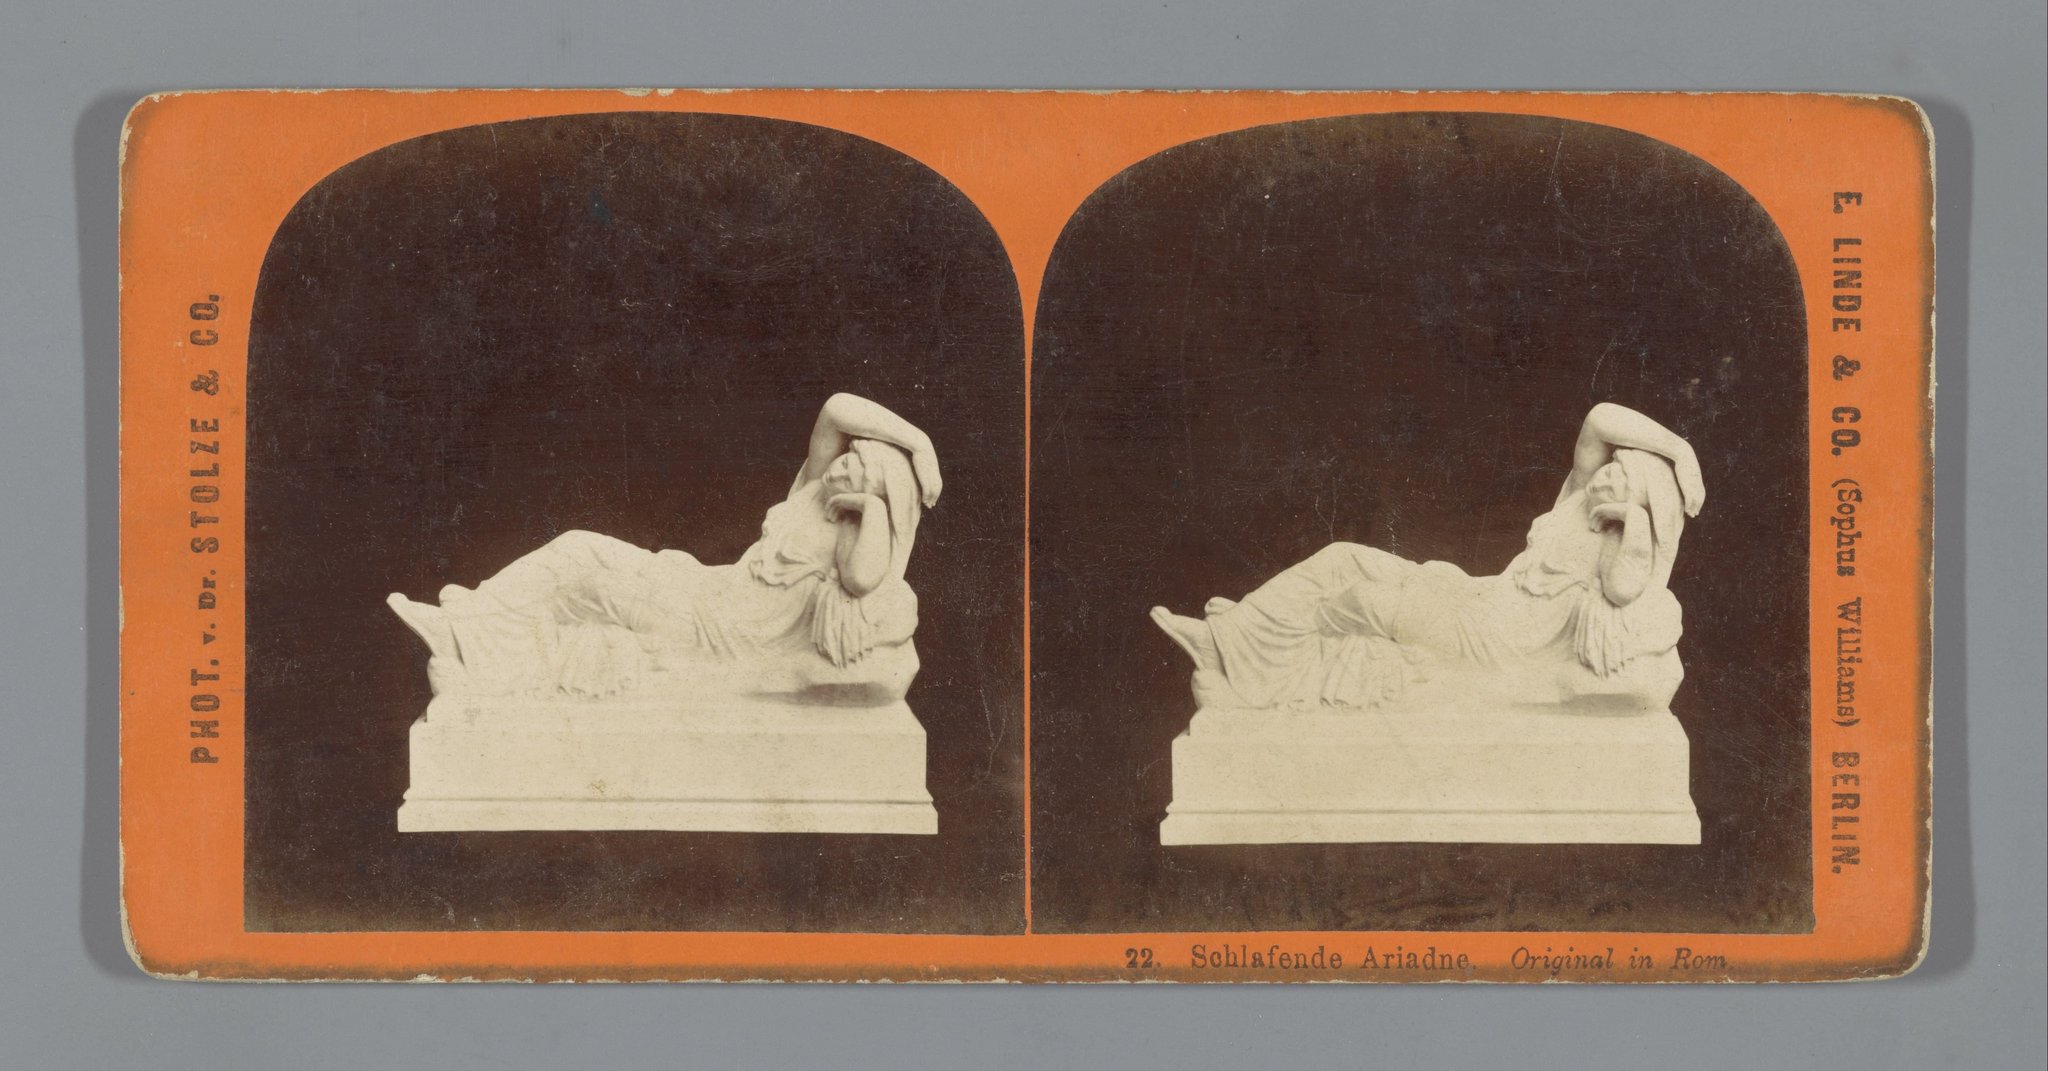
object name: stereograph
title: Sculptuur van de slapende Ariadne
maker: karl heinrich franz stolze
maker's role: fotograaf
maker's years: 1836-1910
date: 1855-1890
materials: cardboard, photographic support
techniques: albumen print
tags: (story of) ariadne, sculpture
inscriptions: number: ‘22’, : ‘Berlin’